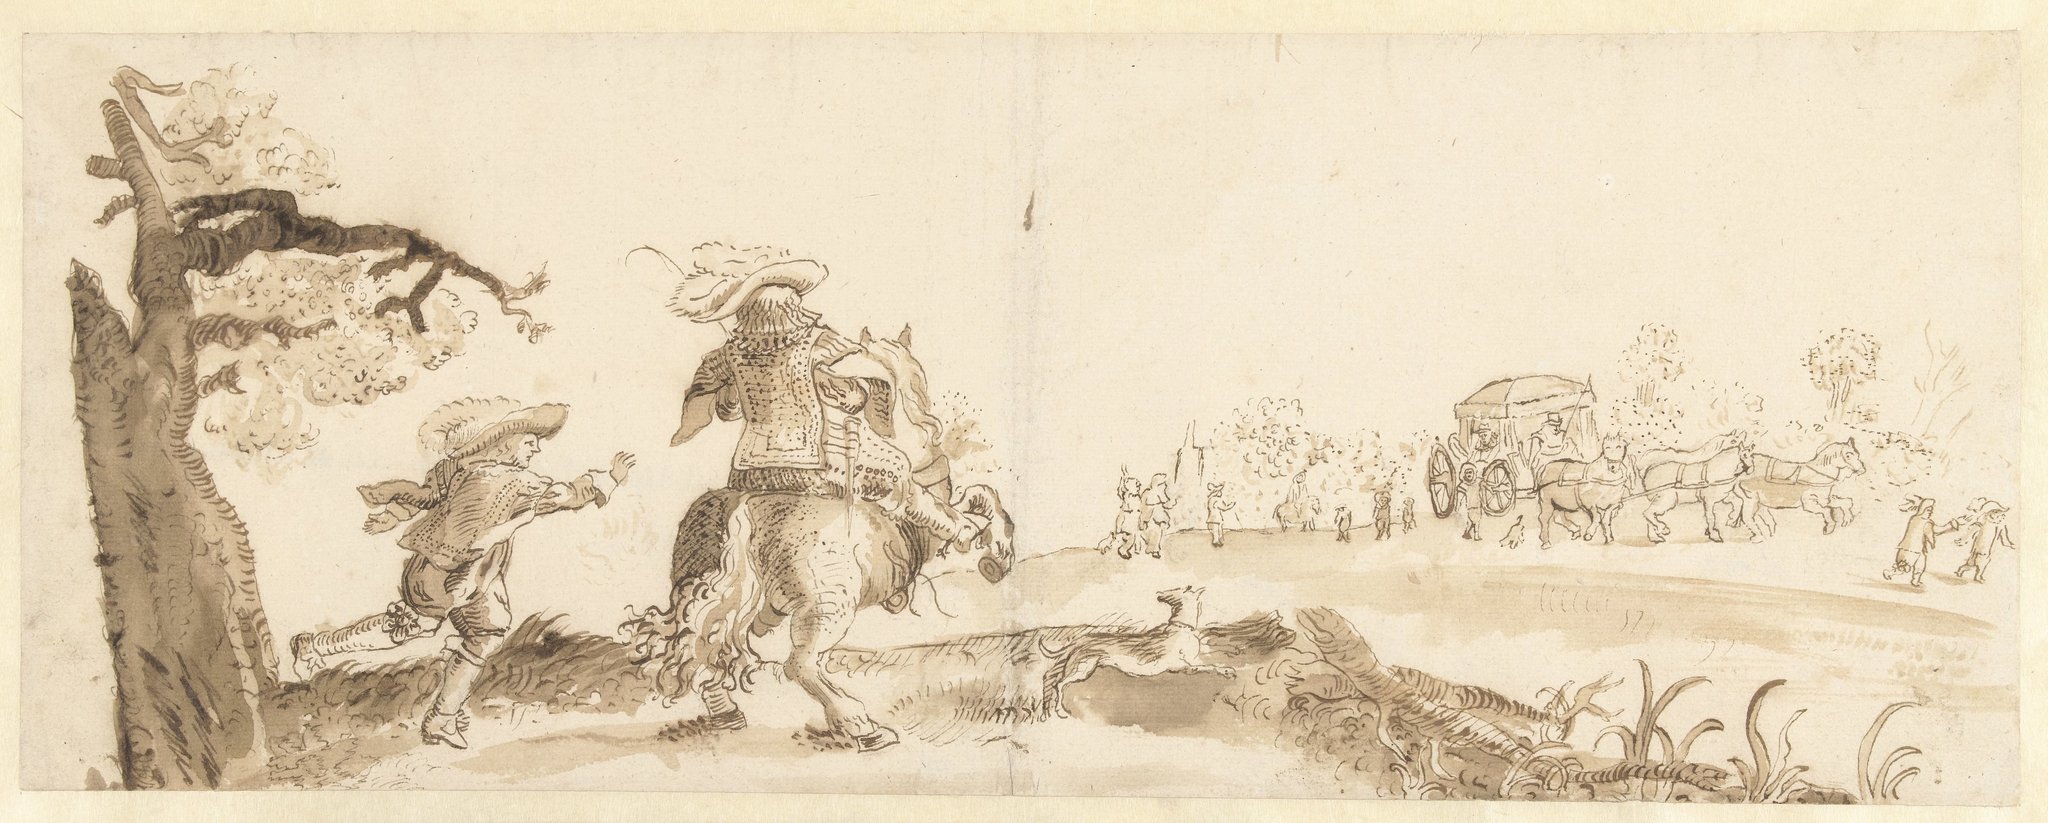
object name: drawing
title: Summer: The Salute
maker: Anonymous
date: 1625-1675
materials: ink, paper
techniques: brush, pen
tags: summer ~ human activities (the four seasons of the year), four-wheeled vehicle drawn by more than three animals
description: Kopie naar prent van Herman Breckerveld.